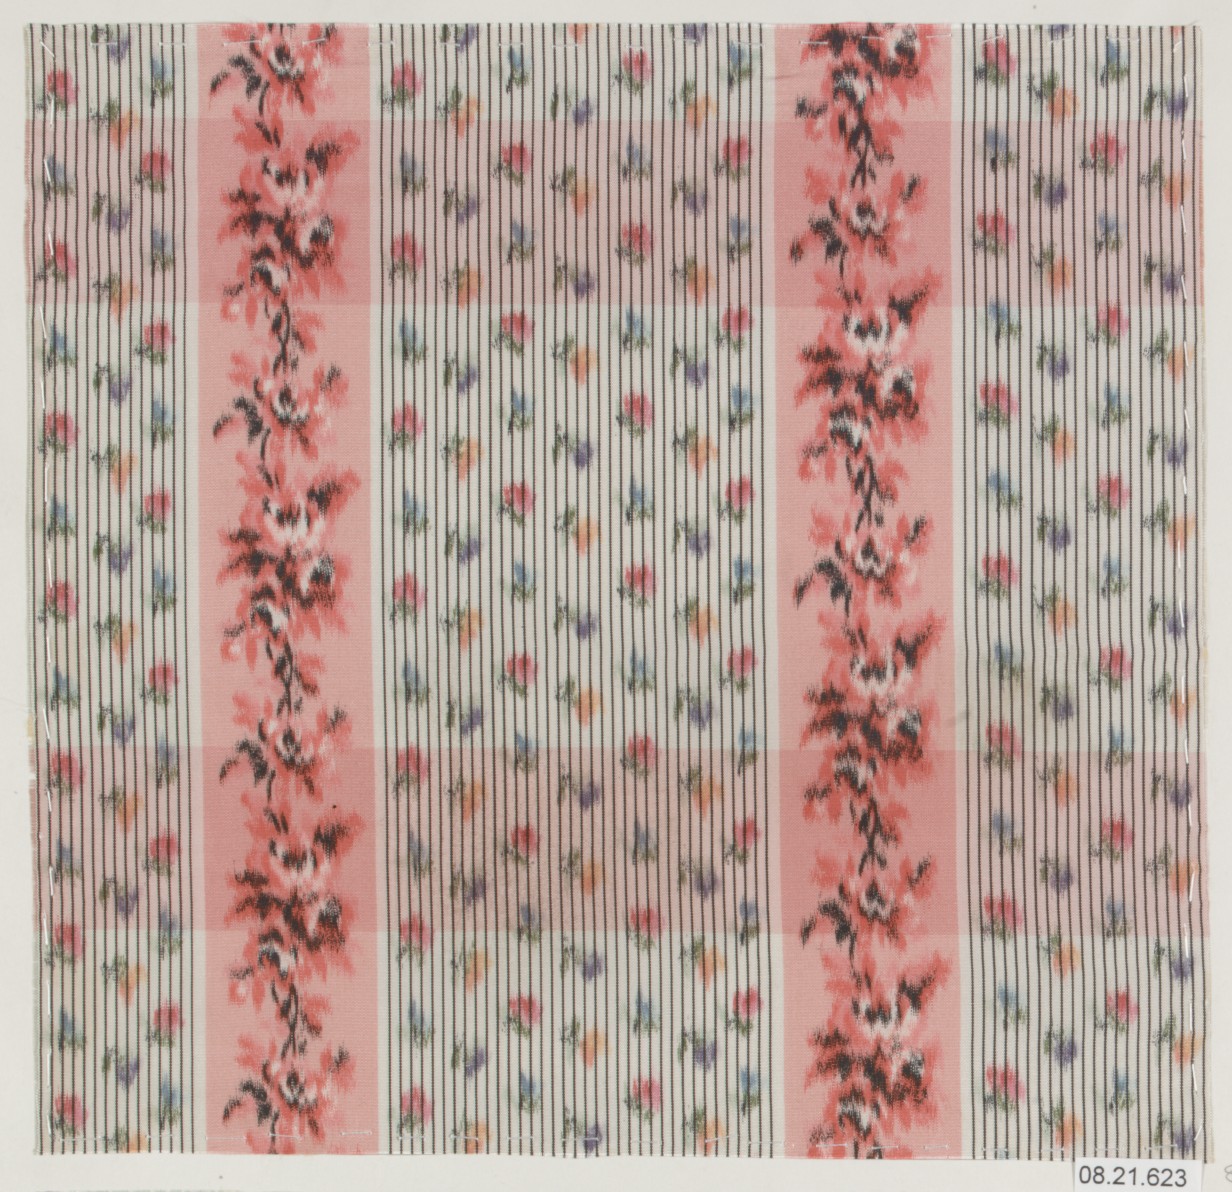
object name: textile sample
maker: Anonymous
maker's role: designer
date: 1900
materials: silk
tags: flowers